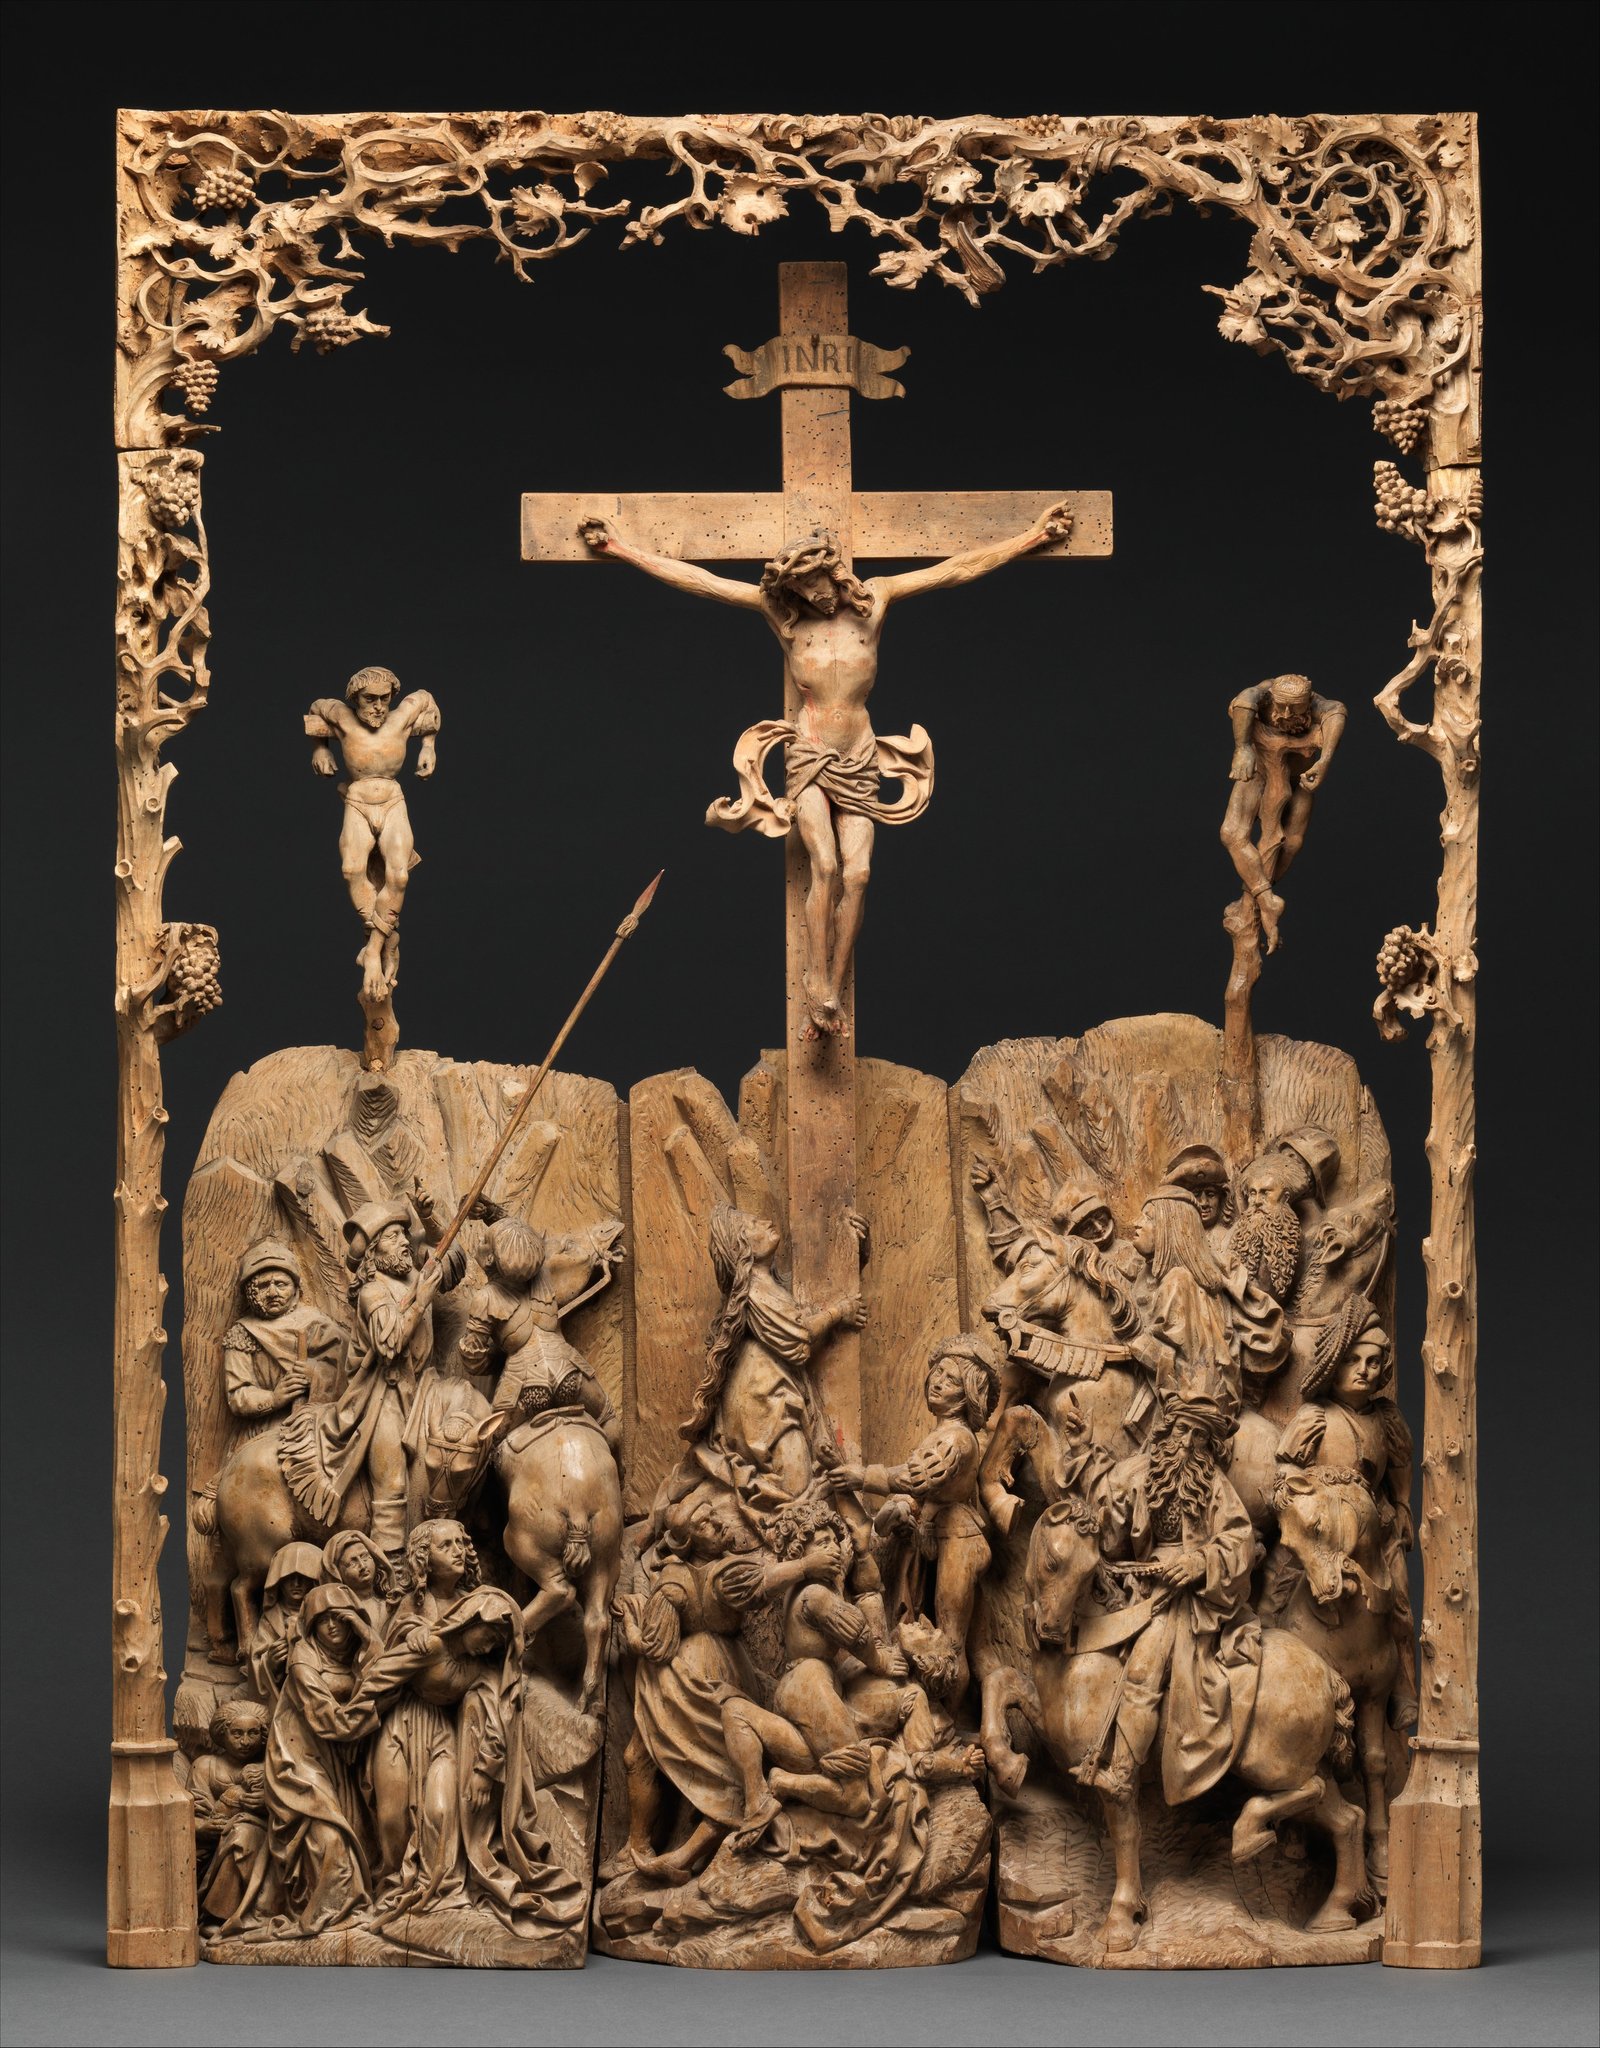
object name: relief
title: Crucifixion Group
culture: german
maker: hans wydytz i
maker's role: artist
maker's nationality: german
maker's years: 1470-1521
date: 1490-1510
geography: germany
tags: spears,men,women,horses,crucifixion